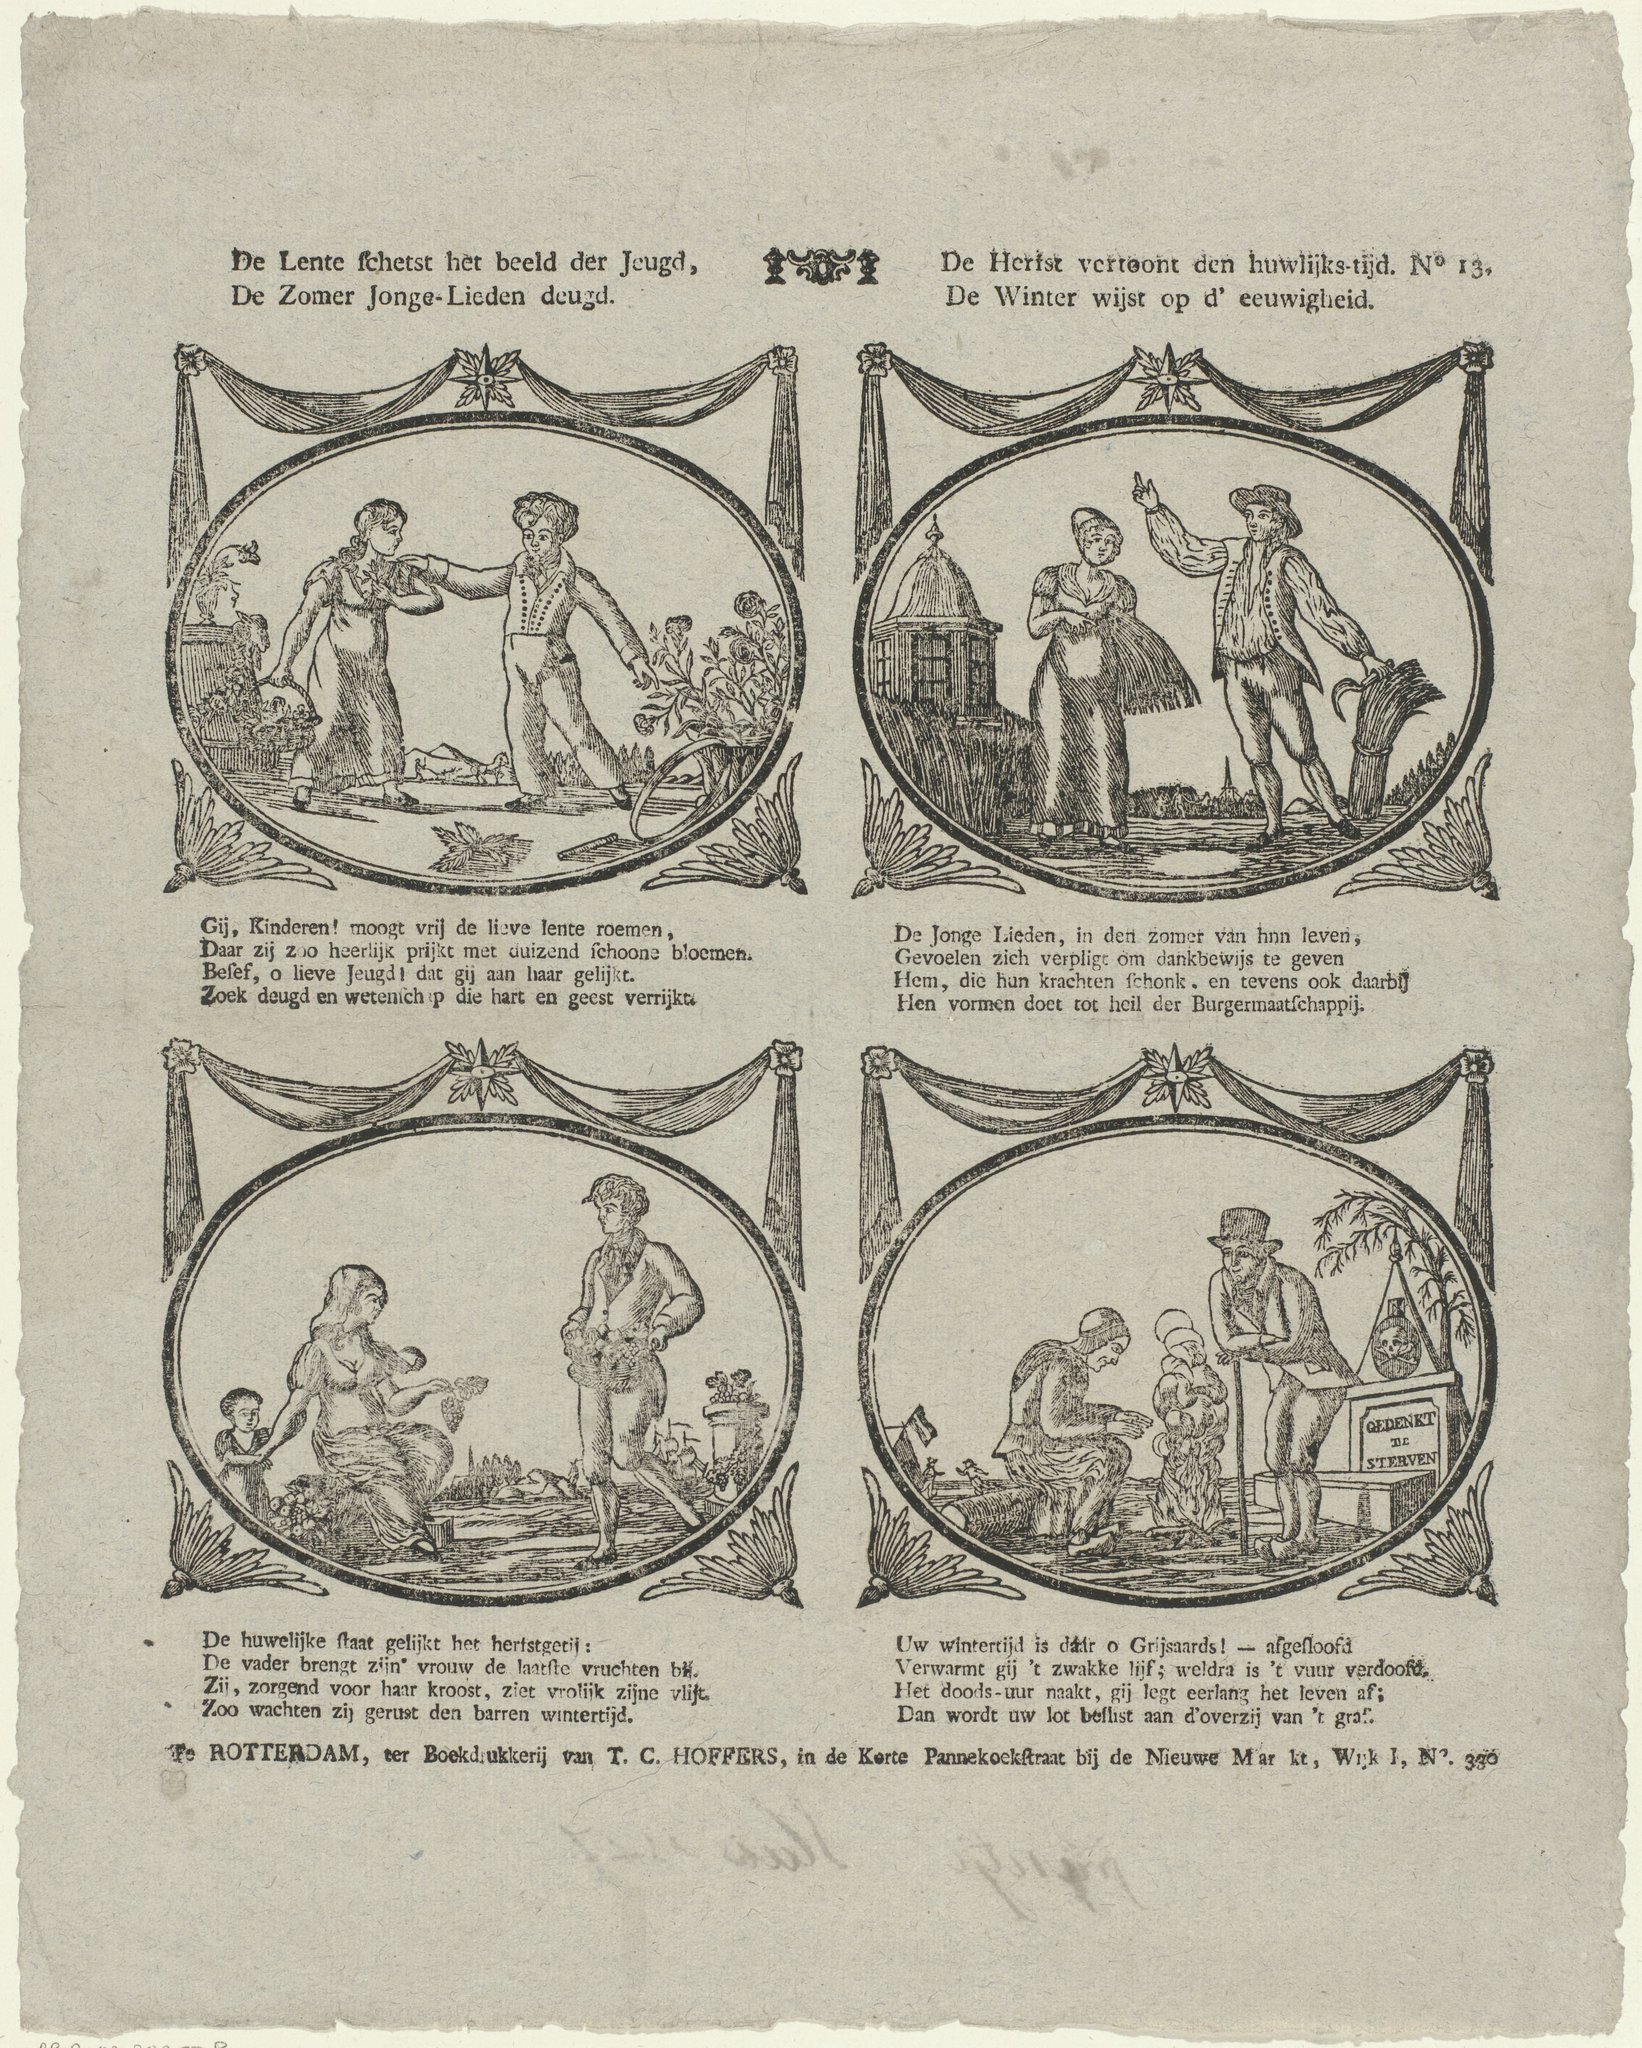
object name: popular print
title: De lent schetst het beeld der jeugd, / De zomer jonge-lieden deugd. / De herfst vertoont den huwelijks-tijd. / De winter wijst op d' eeuwigheid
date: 1820-1838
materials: paper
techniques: letterpress printing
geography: rotterdam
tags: the four seasons of the year ~ human activities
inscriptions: collector's mark: Lugt 2760, inscription: ‘Trijntje Muis 1827’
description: Blad met 4 voorstellingen van de vier jaargetijden in ovale sierlijsten. Onder elke afbeelding een vierregelig vers. Genummerd rechtsboven: No. 13.